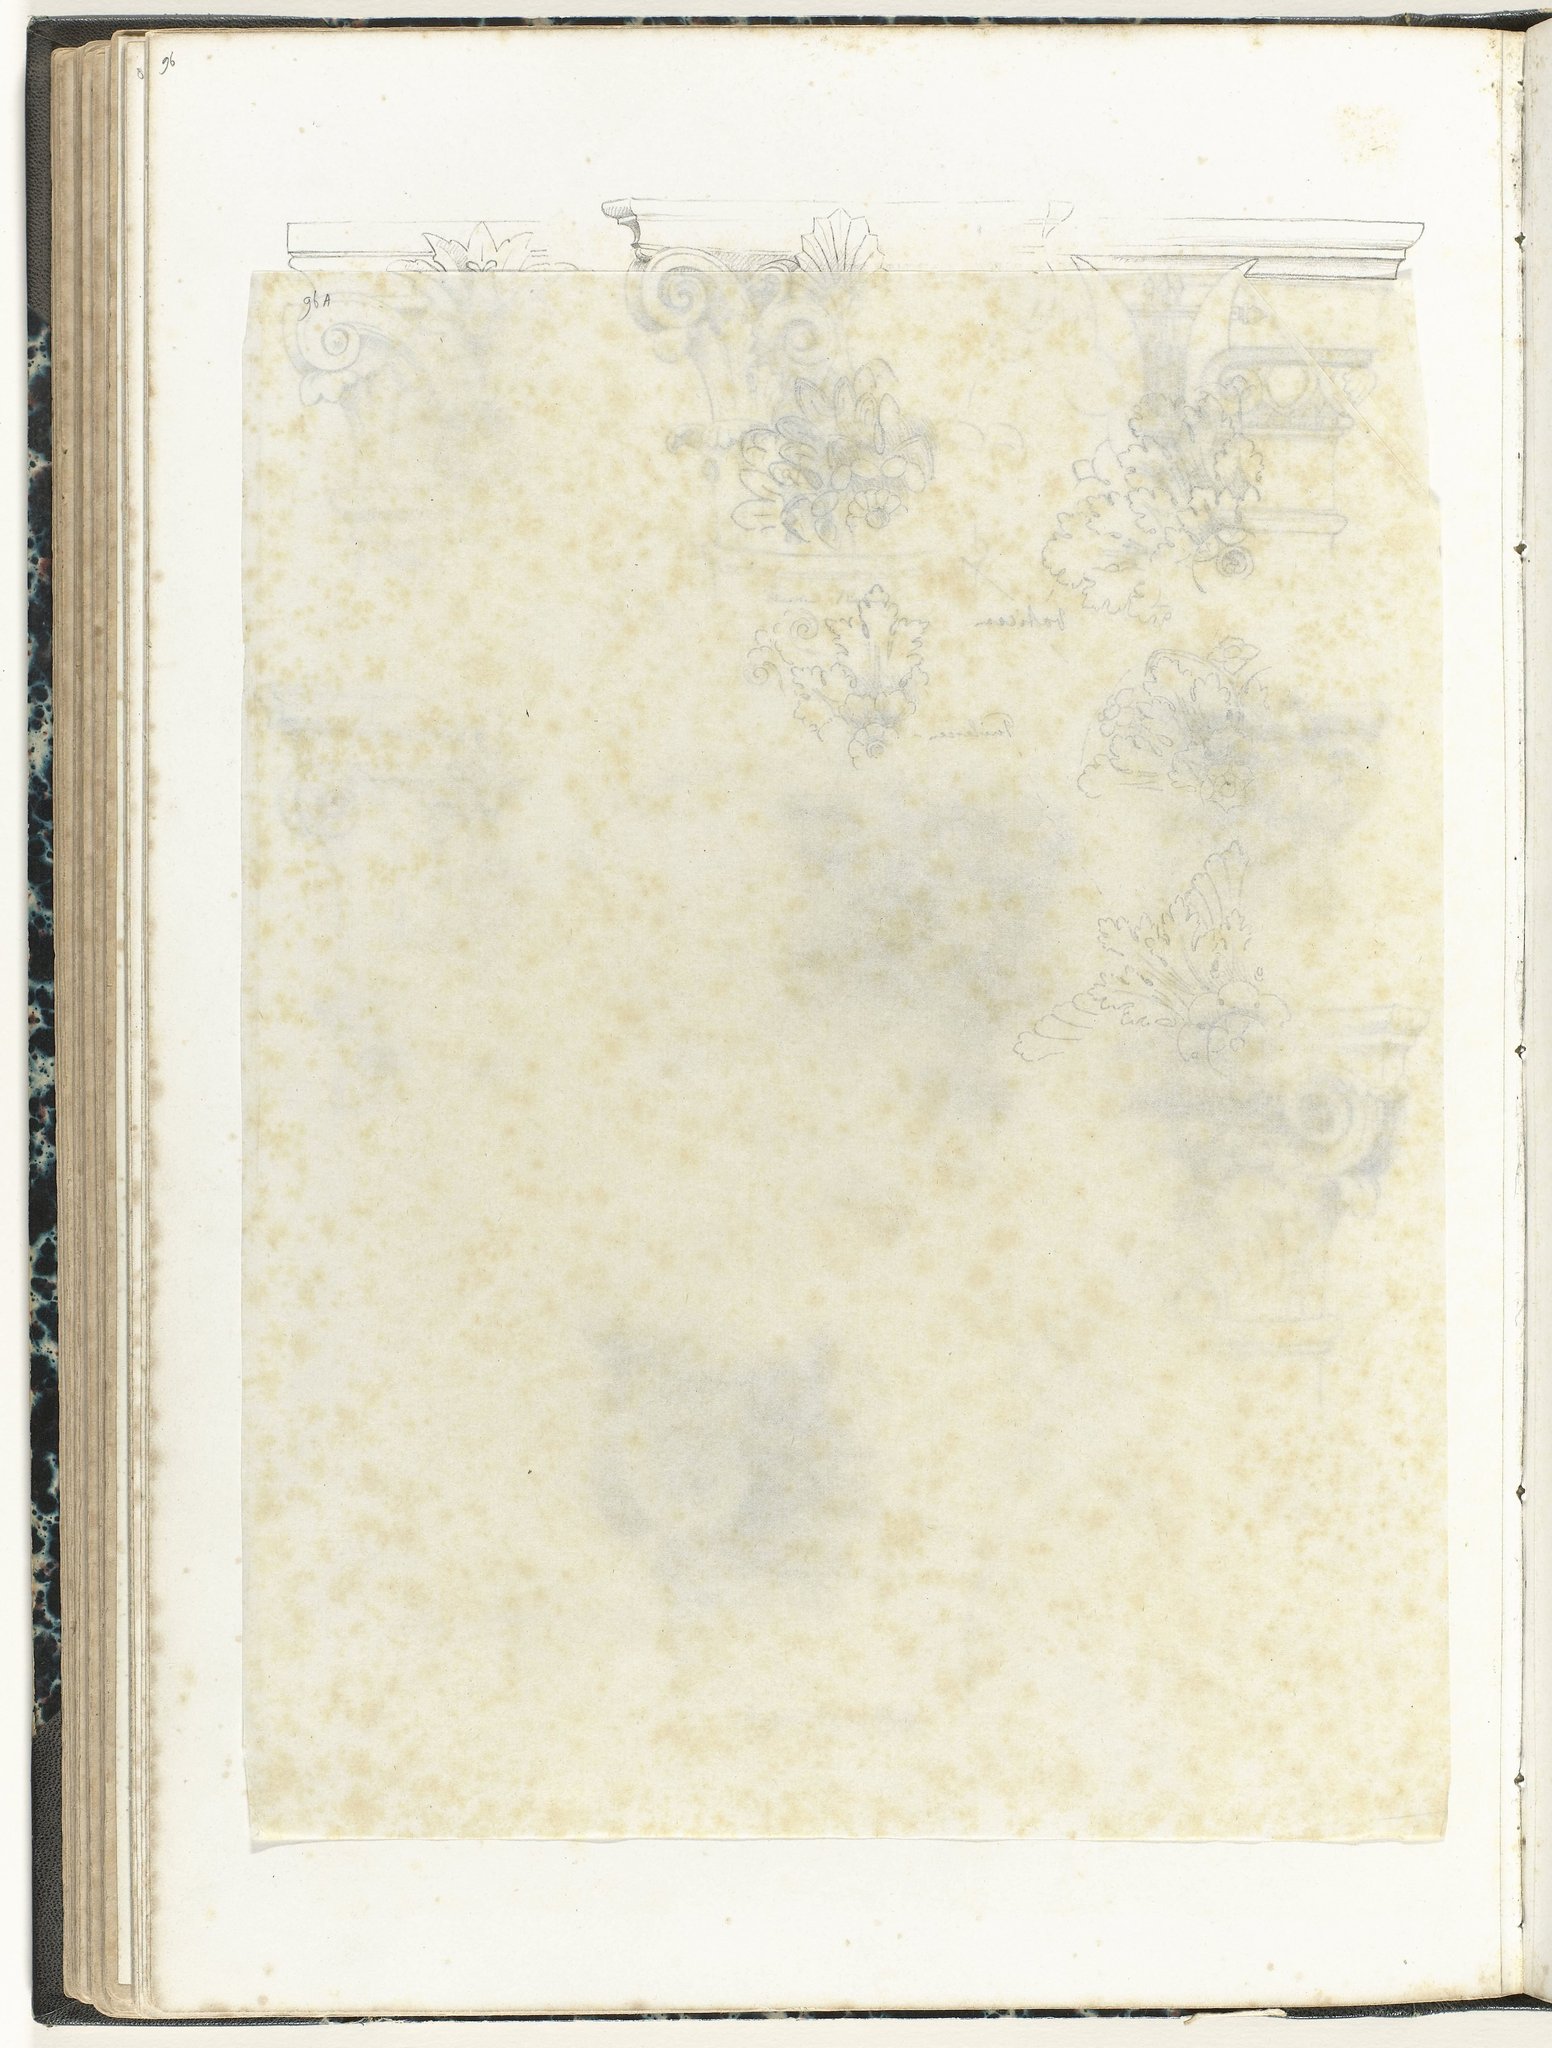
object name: drawing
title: Vijf rozetten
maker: Anonymous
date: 1866-1900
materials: pencil, paper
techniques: drawing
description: Bij drie rozetten staat vermeld: Vaticaan, bij twee: Tuilerien.